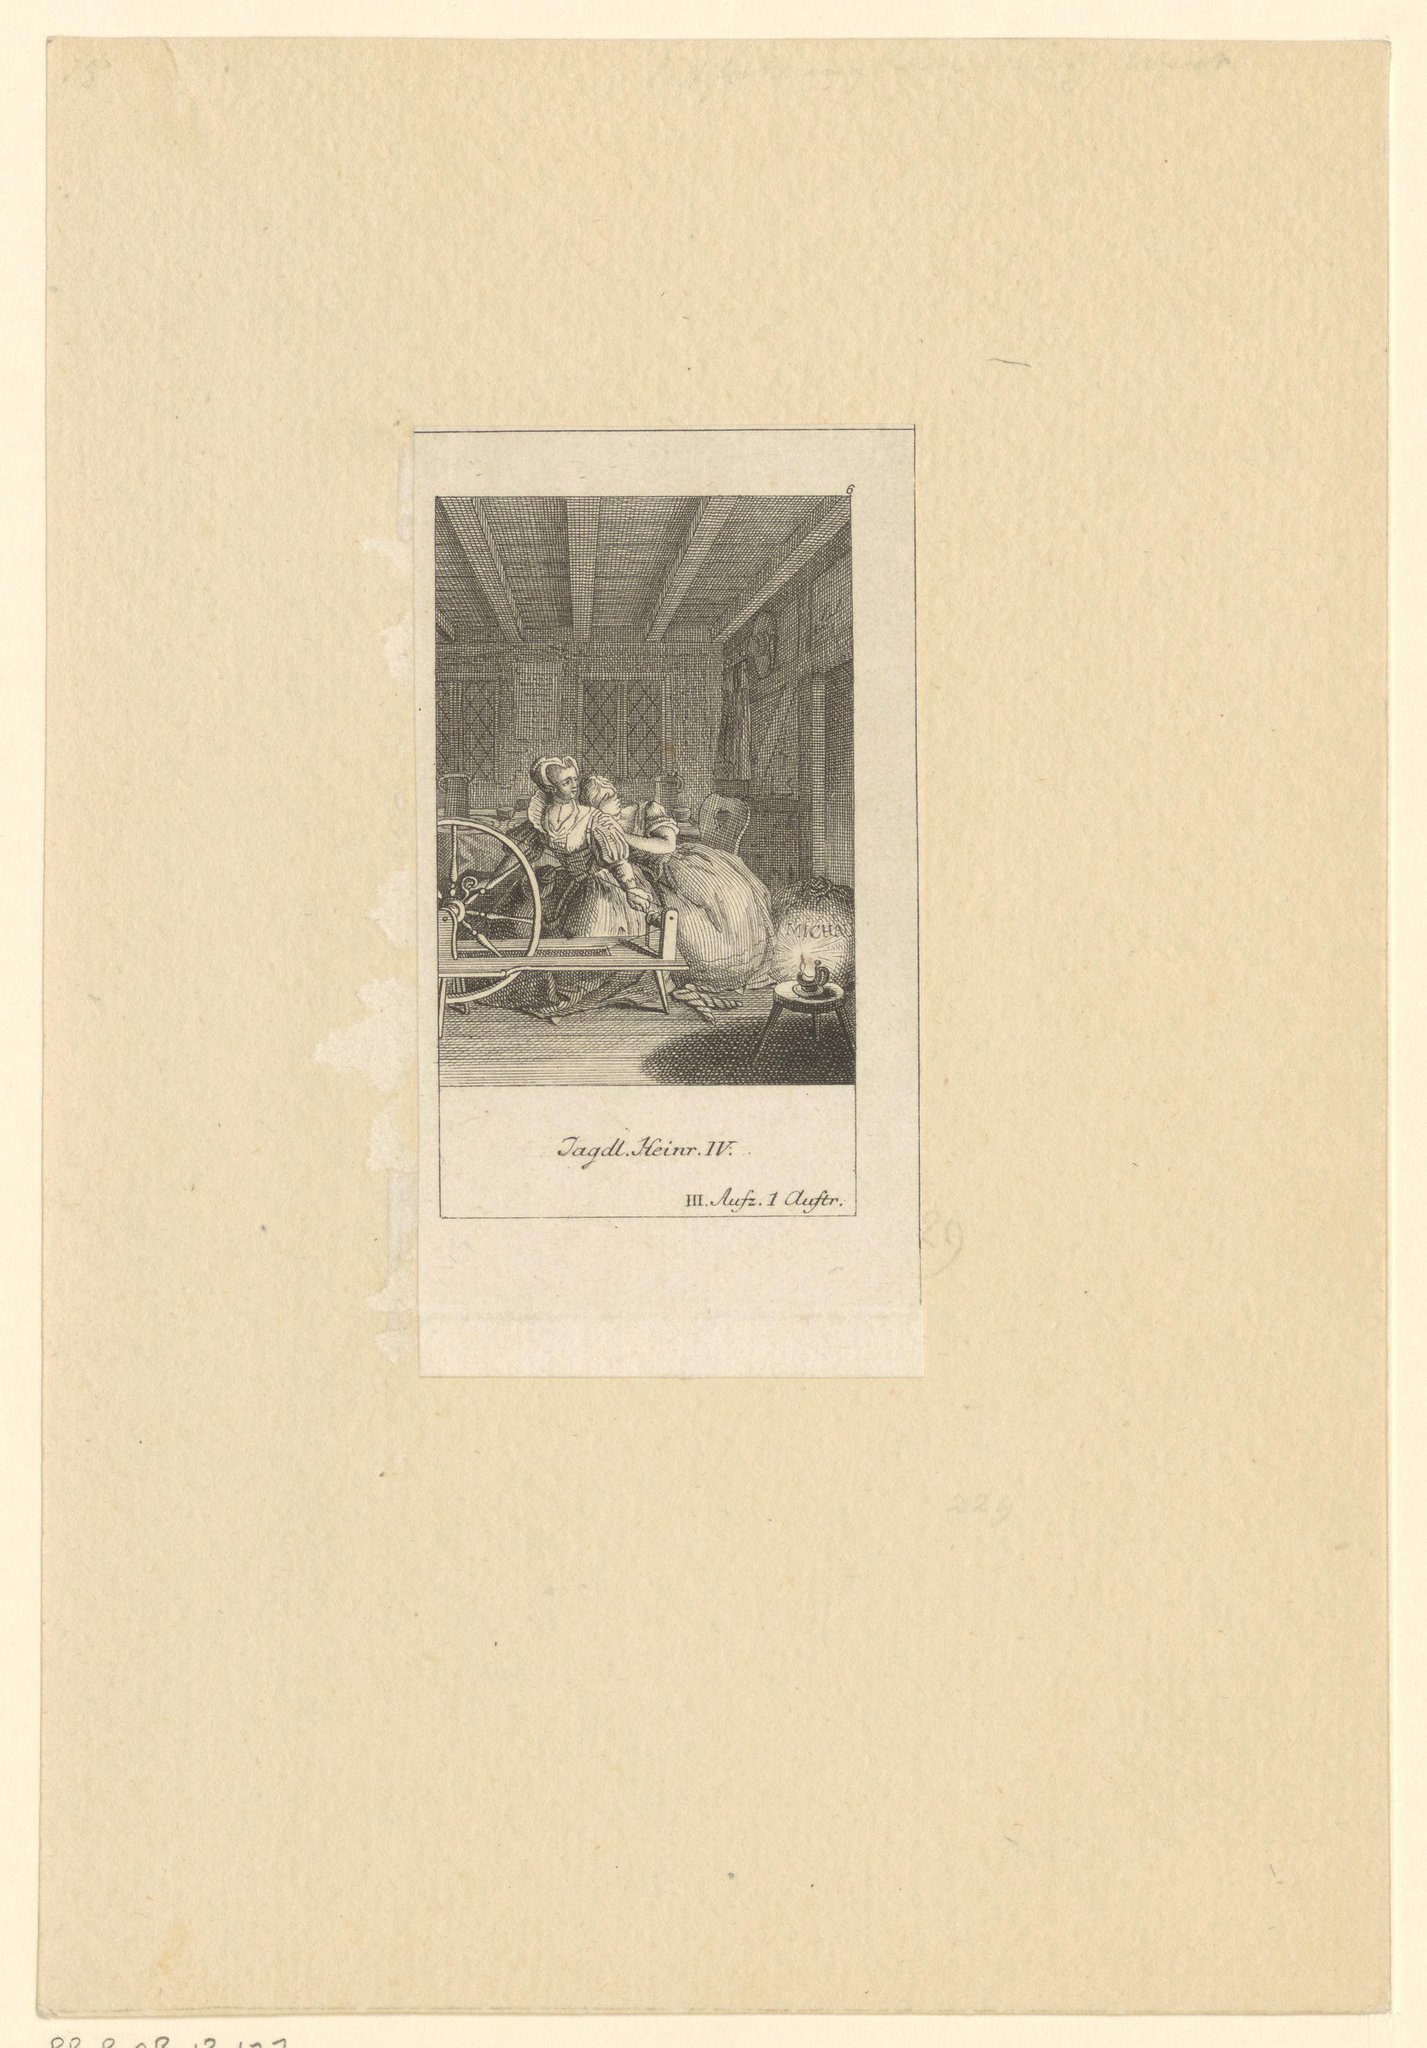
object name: book illustration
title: Margot en haar dochter Catau in het huis van molenaar Michau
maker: daniel berger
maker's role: print maker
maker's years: 1744-1824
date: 1774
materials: paper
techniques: etching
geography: berlin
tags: paris, hendrik iv (koning van frankrijk en navarra), literary characters and objects, mother and daughter(s) (family group)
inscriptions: collector's mark: Lugt 2228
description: Prent afkomstig uit: Genealogischen Calender für West-Preussen auf das Jahr 1775, uitgegeven op kosten van de Konigliche Academie der Wissenschaften. Deze prent maakt deel uit van een serie van twaalf prenten, gedrukt van een koperplaat. De prenten tonen scènes uit het toneelstuk 'La partie de chasse de Henri IV' (1767) van Charles Collé.